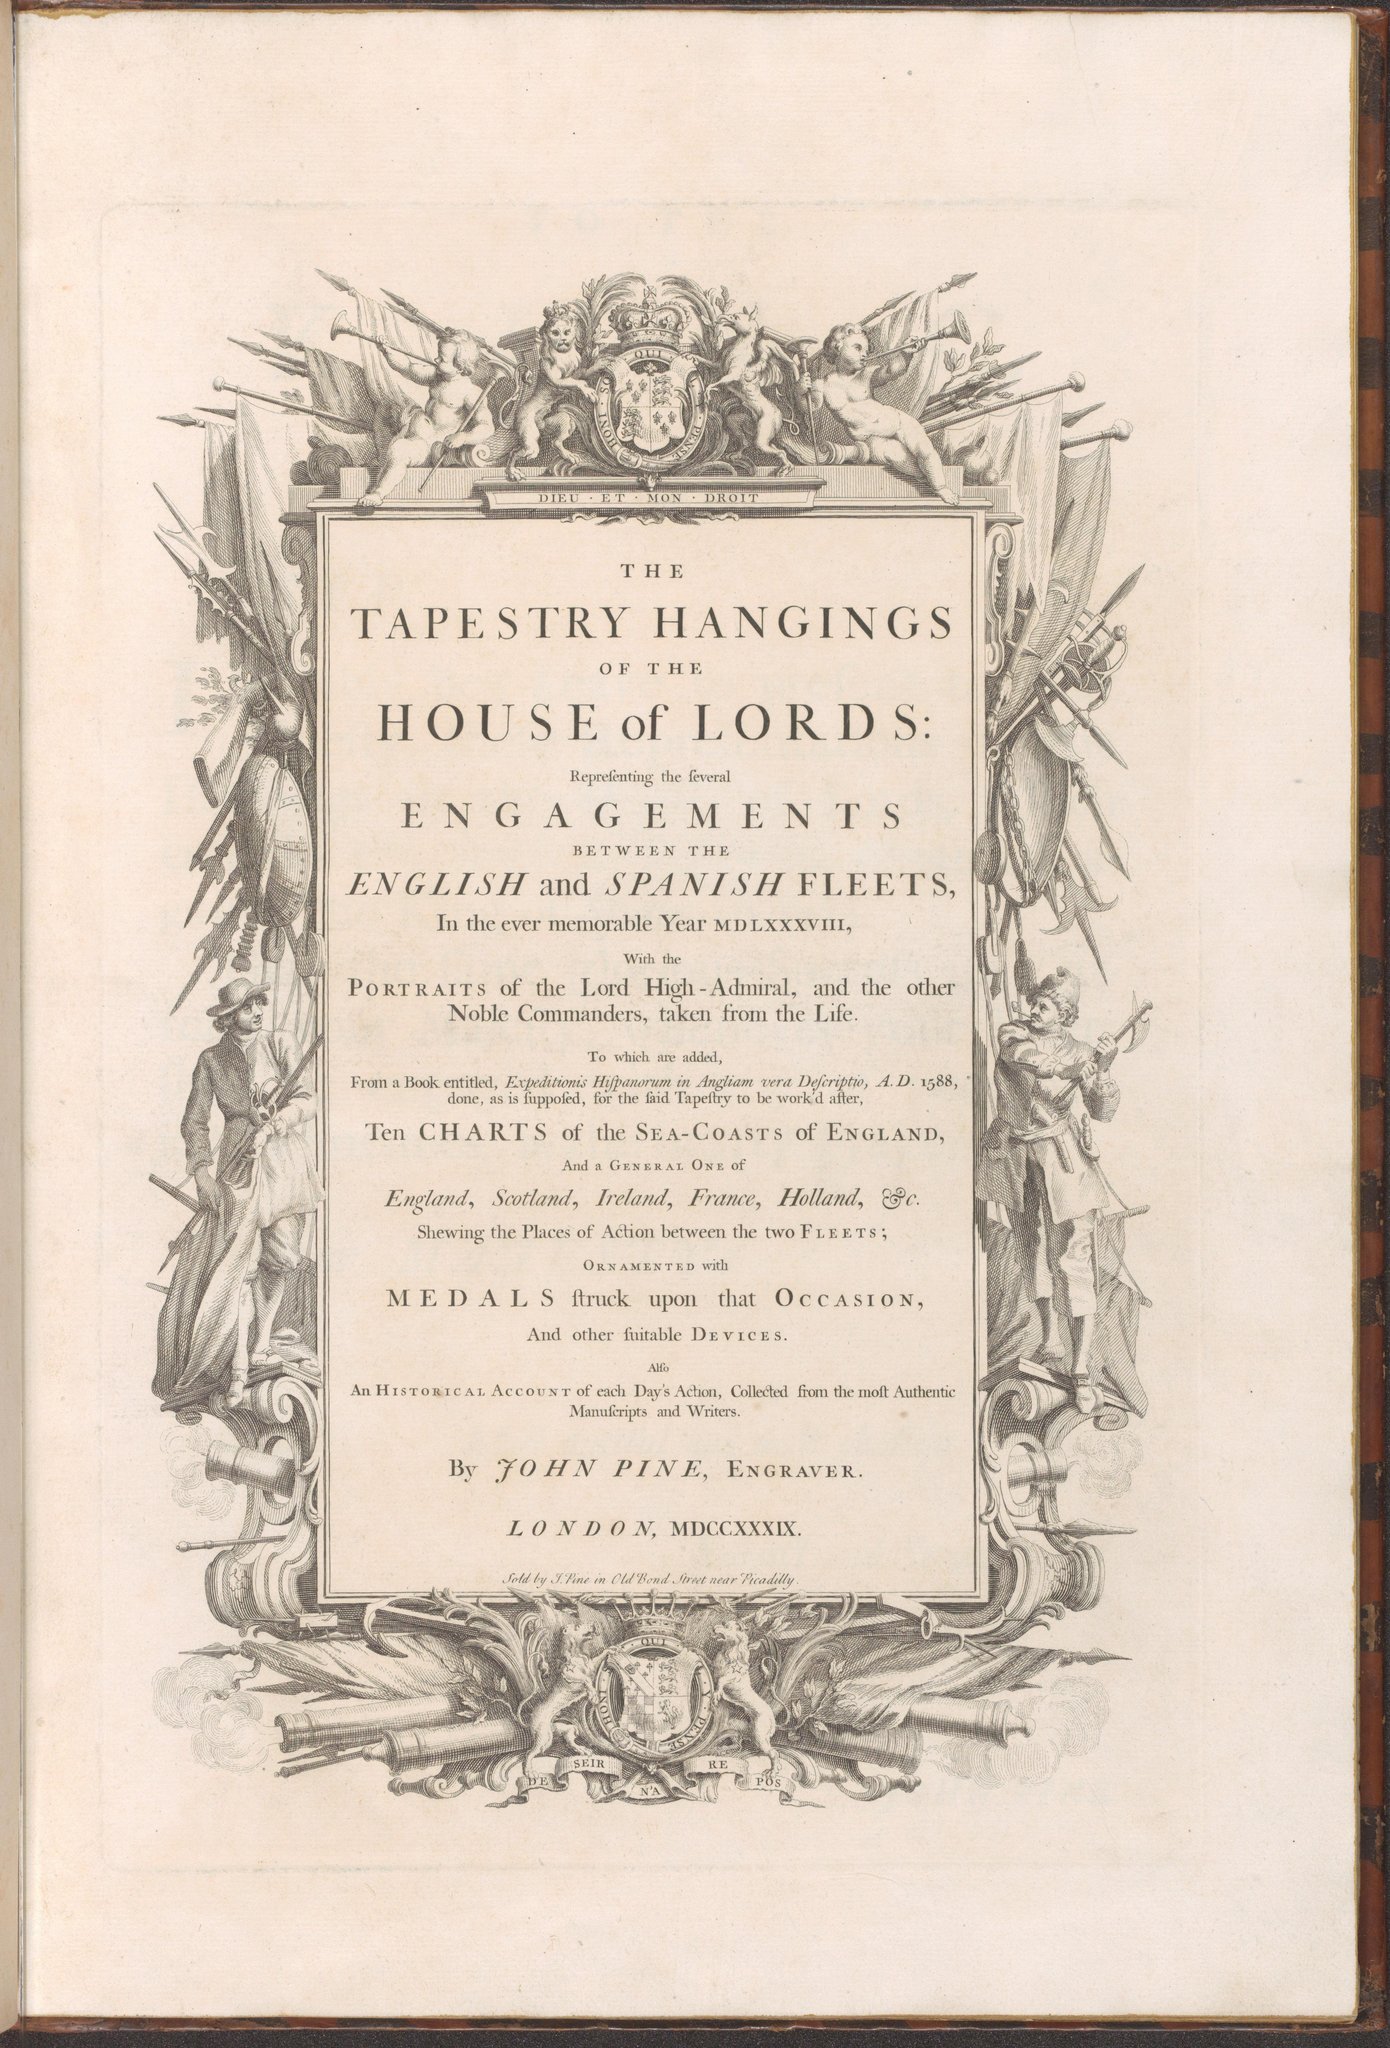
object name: print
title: Titelpagina voor: The Tapestry Hangings of the House of Lords, 1739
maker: john pine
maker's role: print maker, publisher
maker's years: 1690-1756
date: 1739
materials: paper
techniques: engraving, etching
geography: london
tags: coat of arms (symbol of sovereignty), title-page, weapons, calligraphy, armorial bearing, heraldry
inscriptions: date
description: Cartouche met titel, geflankeerd door twee gewapende mannen in een ornamentrand van speren, schilden, kanonnen en ander wapentuig. Bovenaan het wapen van de Engelse koningin Elizabeth I, met het devies: Dieu et mon droit. Onderaan het wapen van Charles Howard (opperbevelhebber van de Engelse vloot tegen de Spaanse Armada), met het devies: Deseir n'a repos. De prent maakt deel uit van een boek over de Spaanse Armada en de tapijten die daarover in opdracht van Howard werden gemaakt.